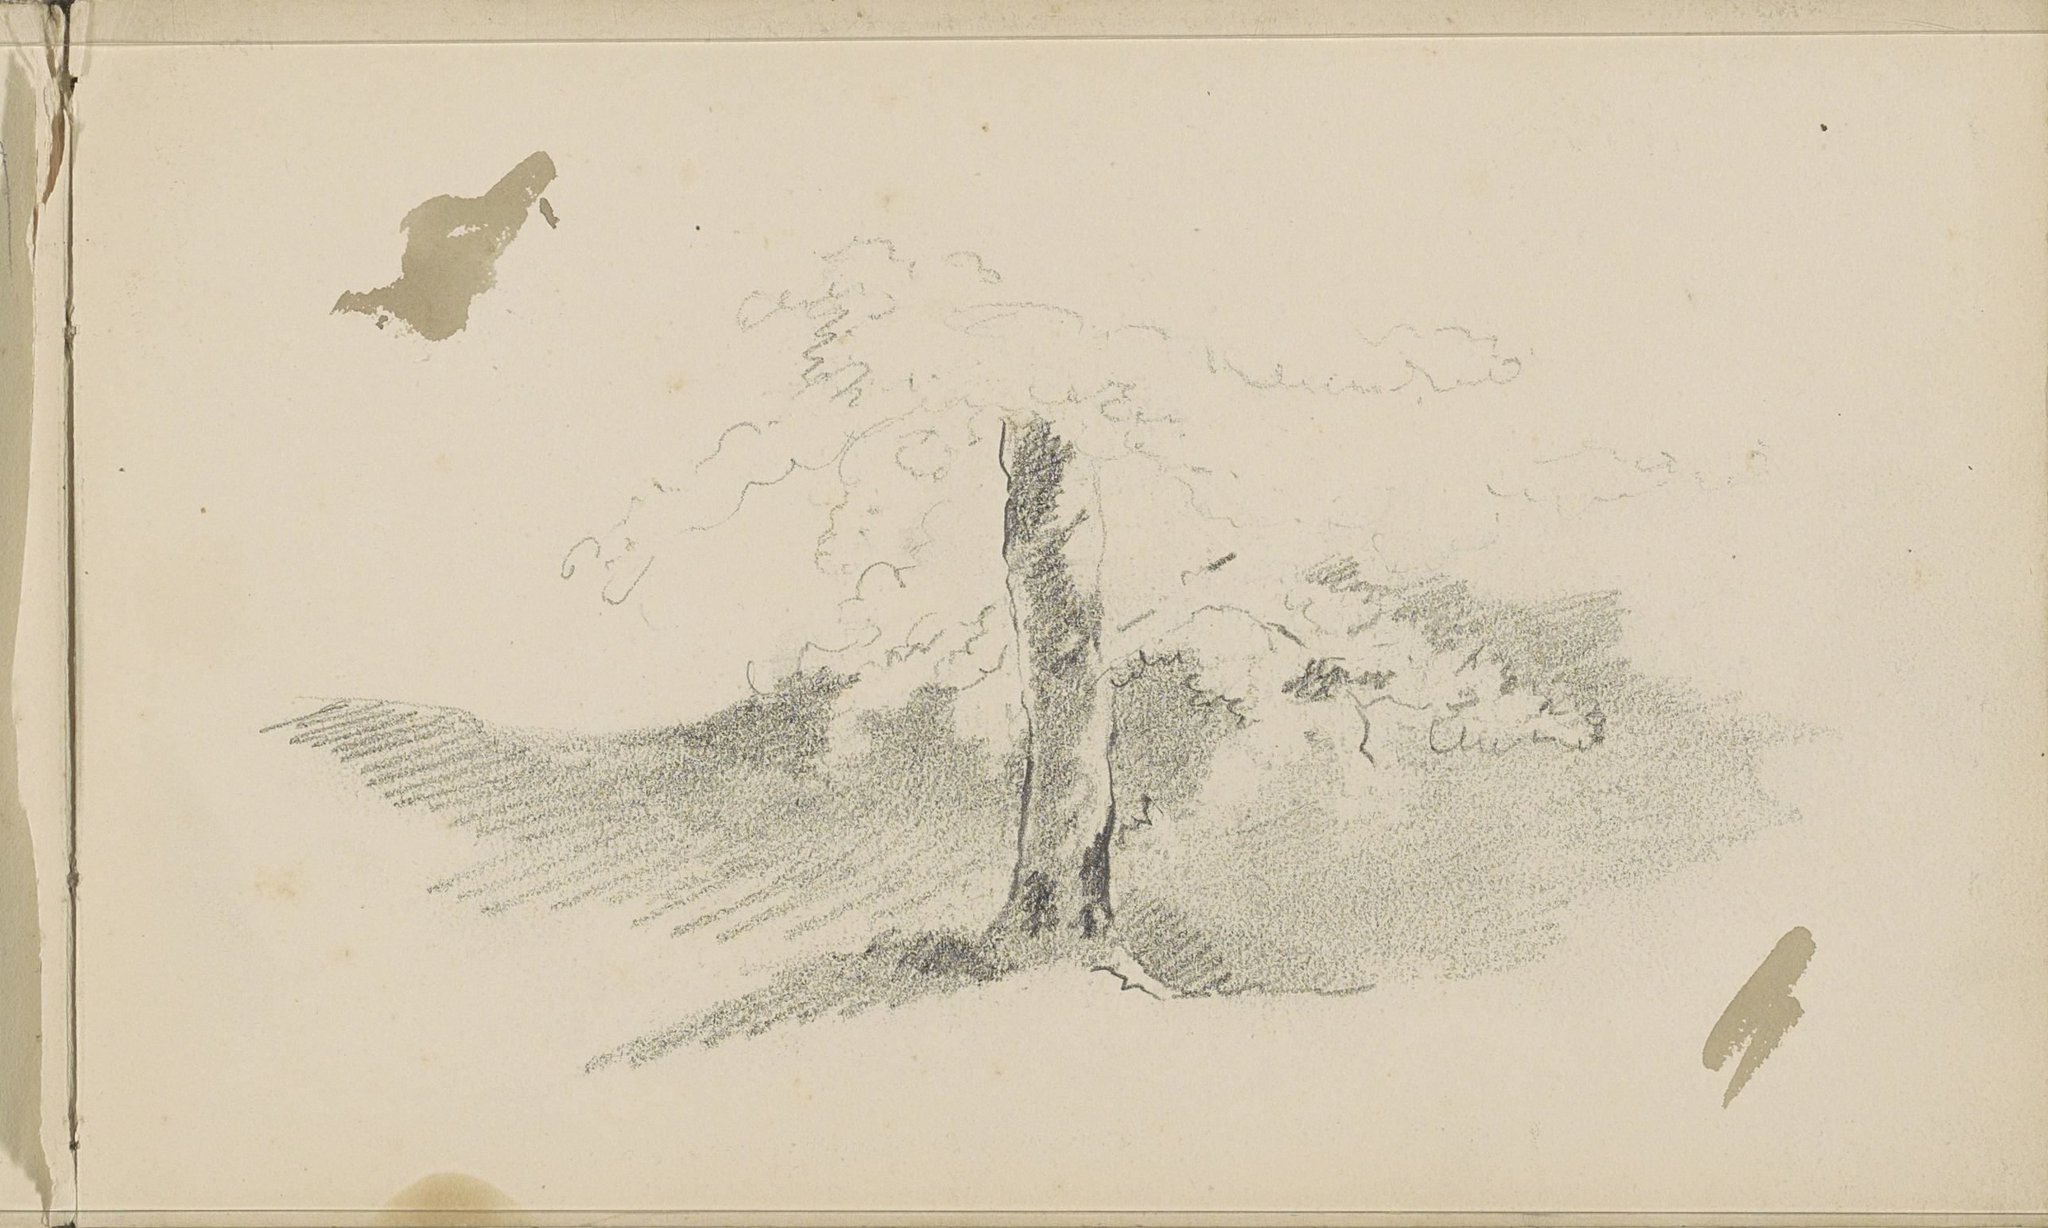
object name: sketchbook leaf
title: Boom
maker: anna catharina maria van eeghen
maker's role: draughtsman, print maker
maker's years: 1878-1924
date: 1888-1901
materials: paper, pencil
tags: trees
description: Blad 1 recto uit een schetsboek met 33 bladen.